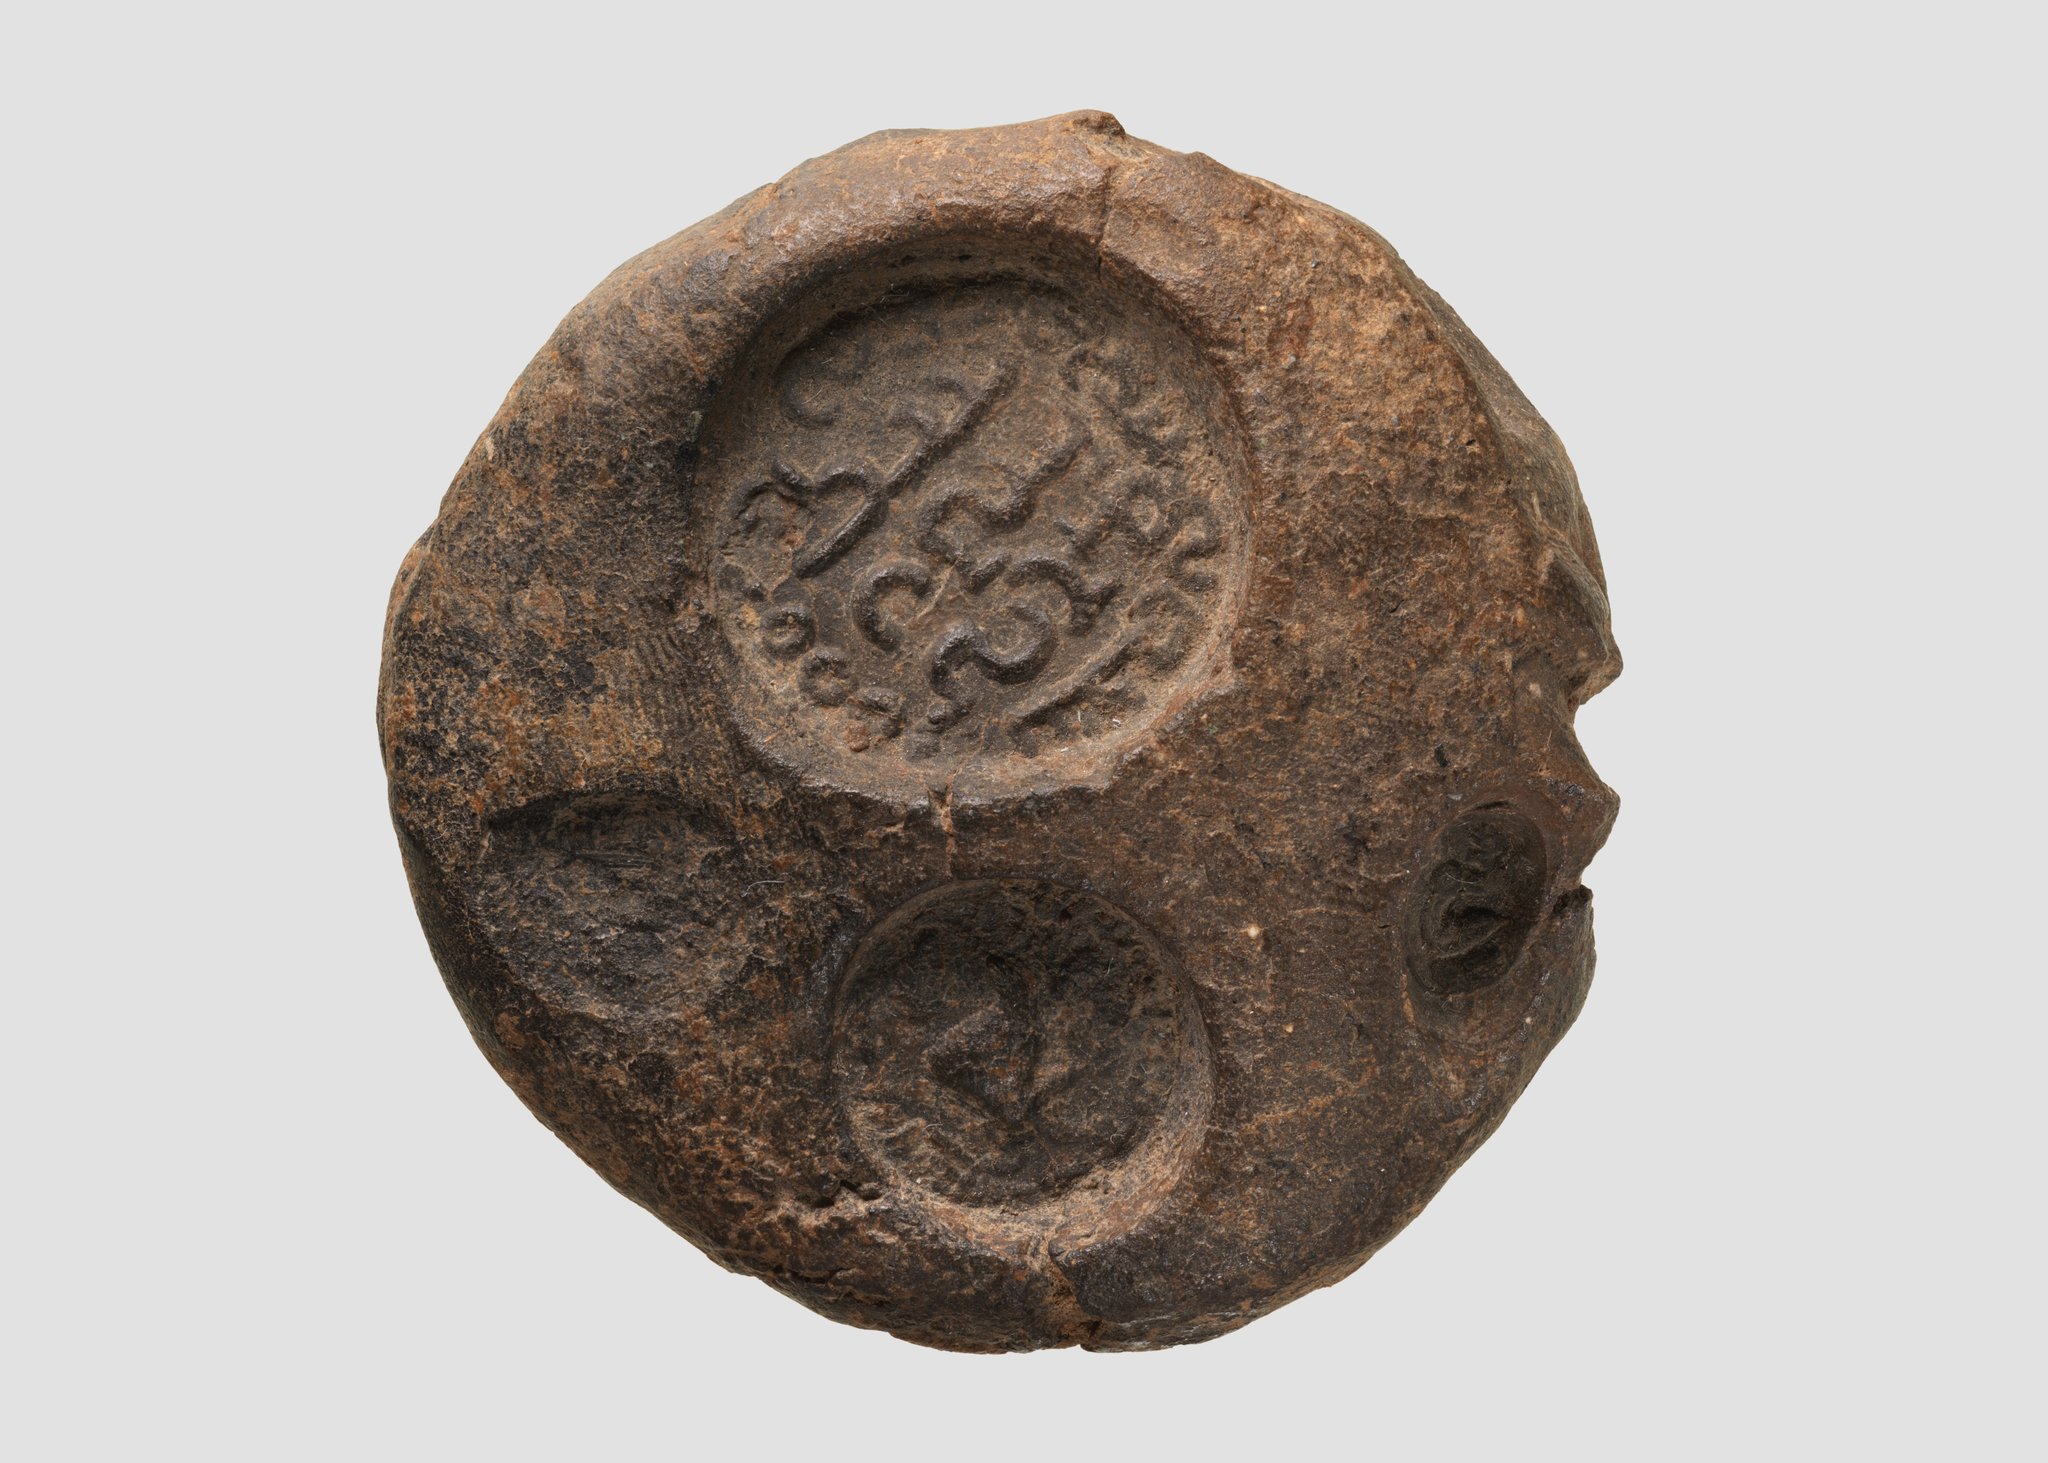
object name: sealing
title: Sealing with inscribed stamp seal impressions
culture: sasanian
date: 501-700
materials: ceramic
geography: iran